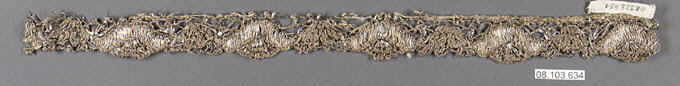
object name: piece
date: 1701-1733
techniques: lace